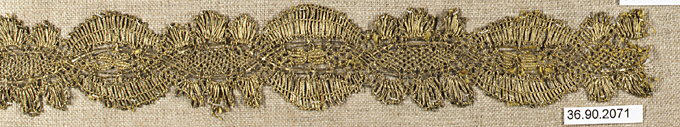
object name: piece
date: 1801-1900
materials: metal thread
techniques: lace